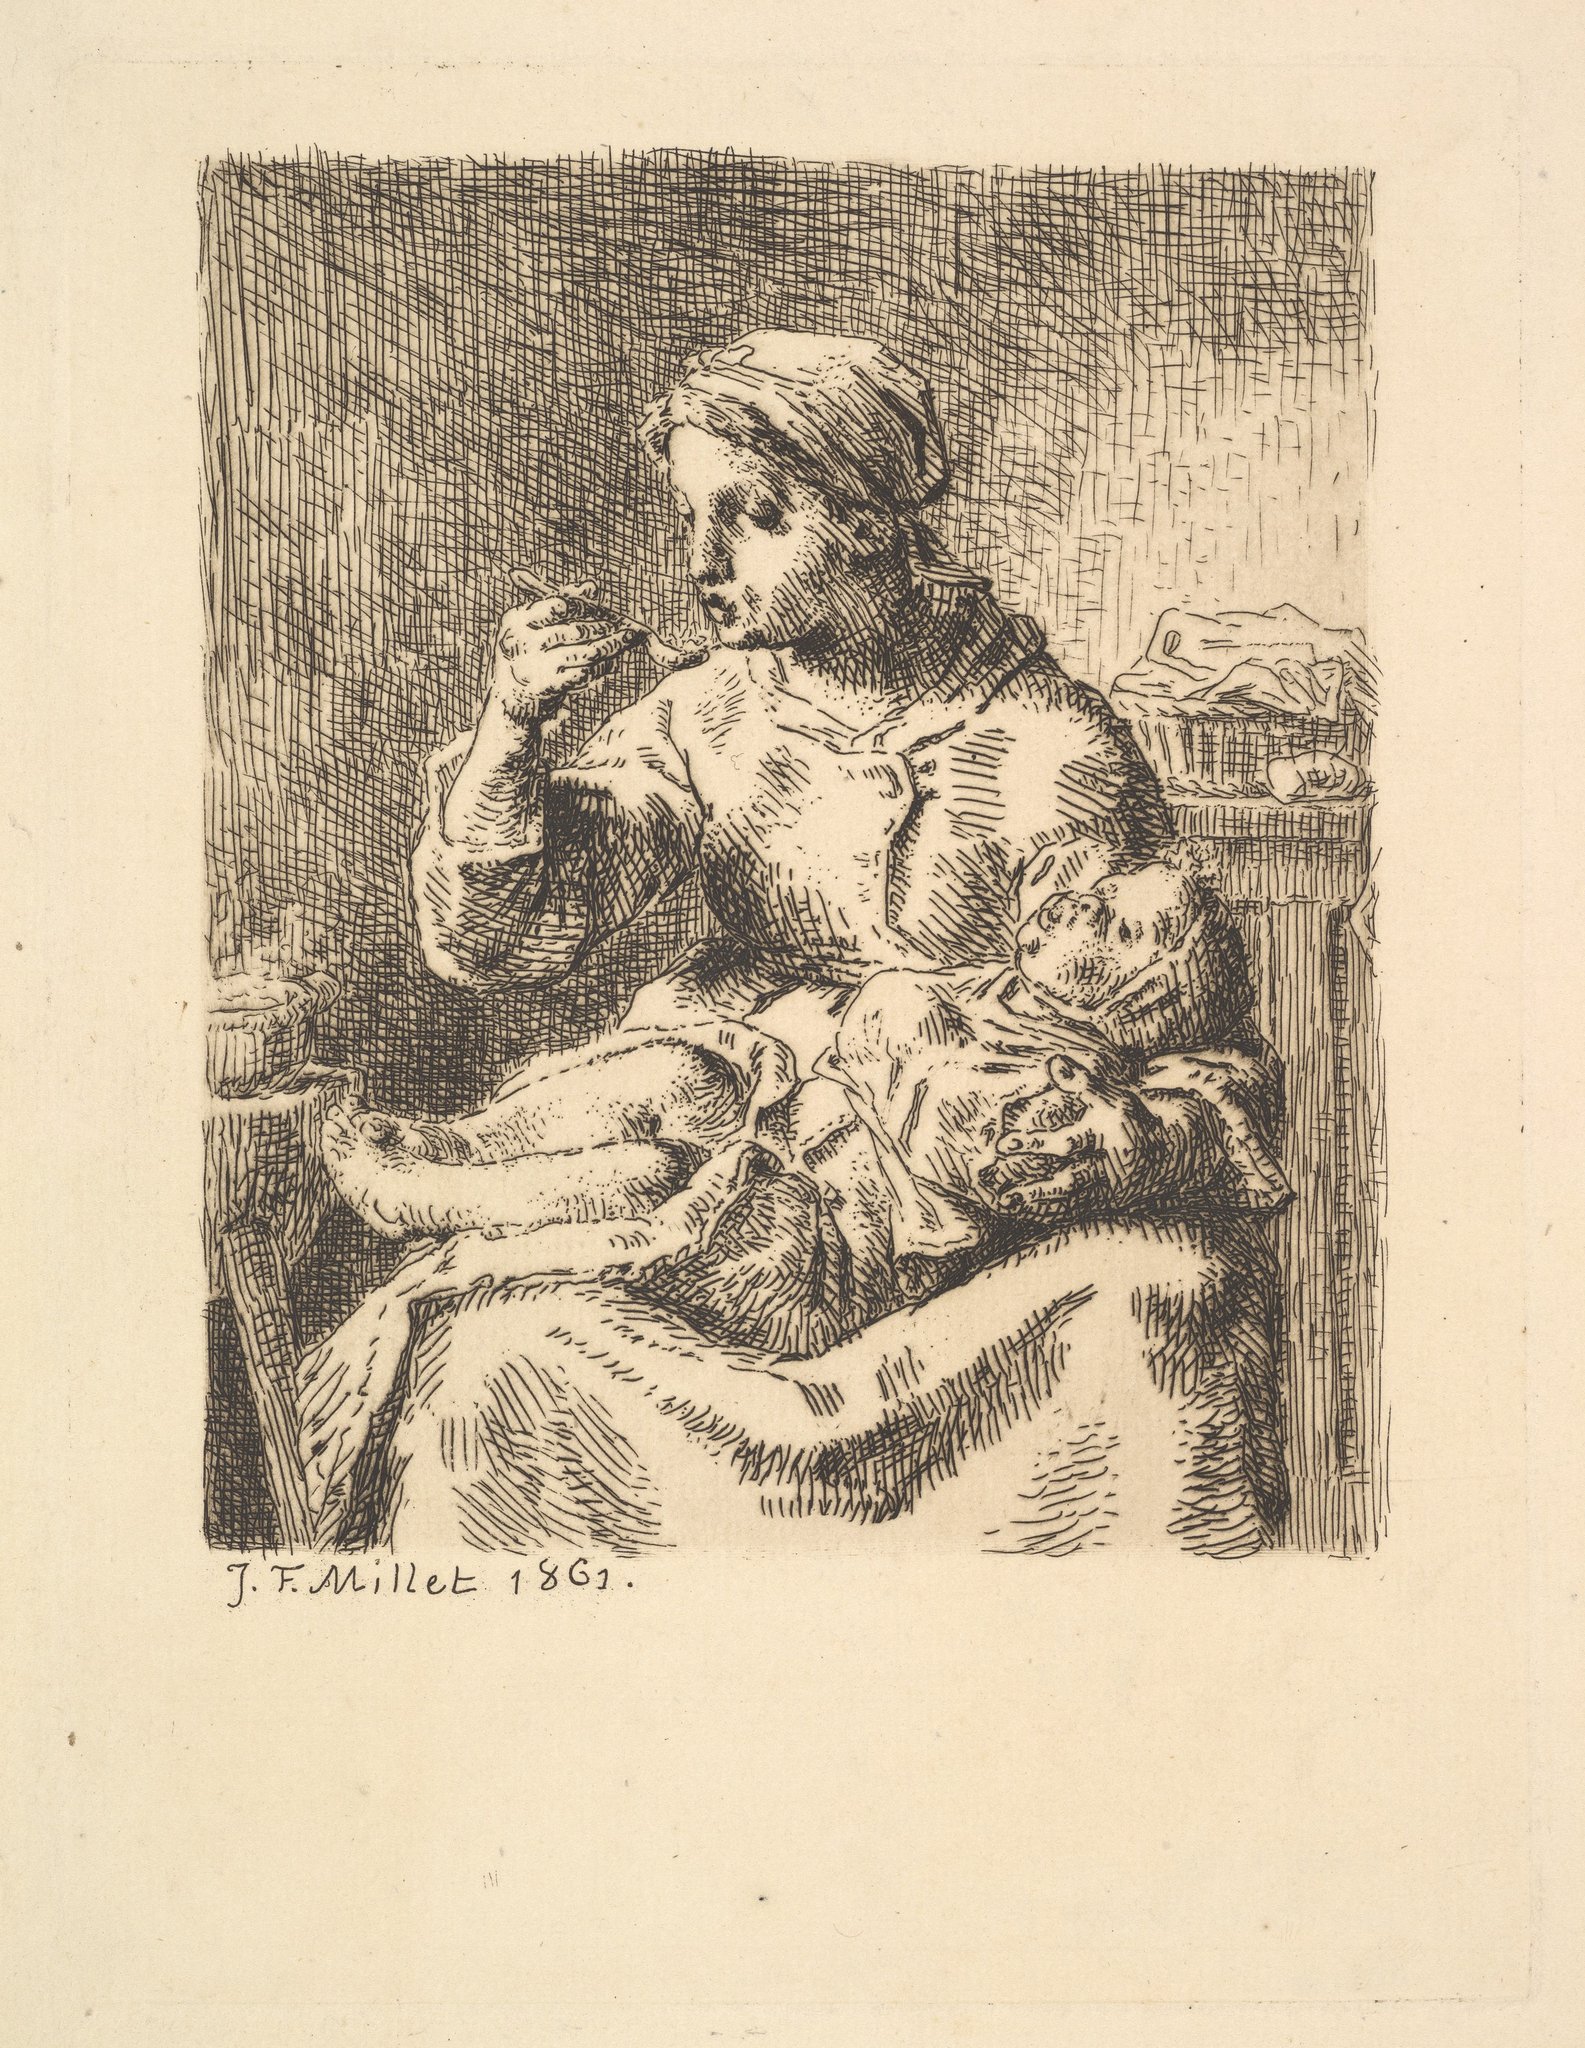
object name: print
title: Cooling the Porridge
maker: jean-françois millet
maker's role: artist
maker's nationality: french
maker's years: 1814-1875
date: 1861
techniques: etching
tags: food,infants,women,eating